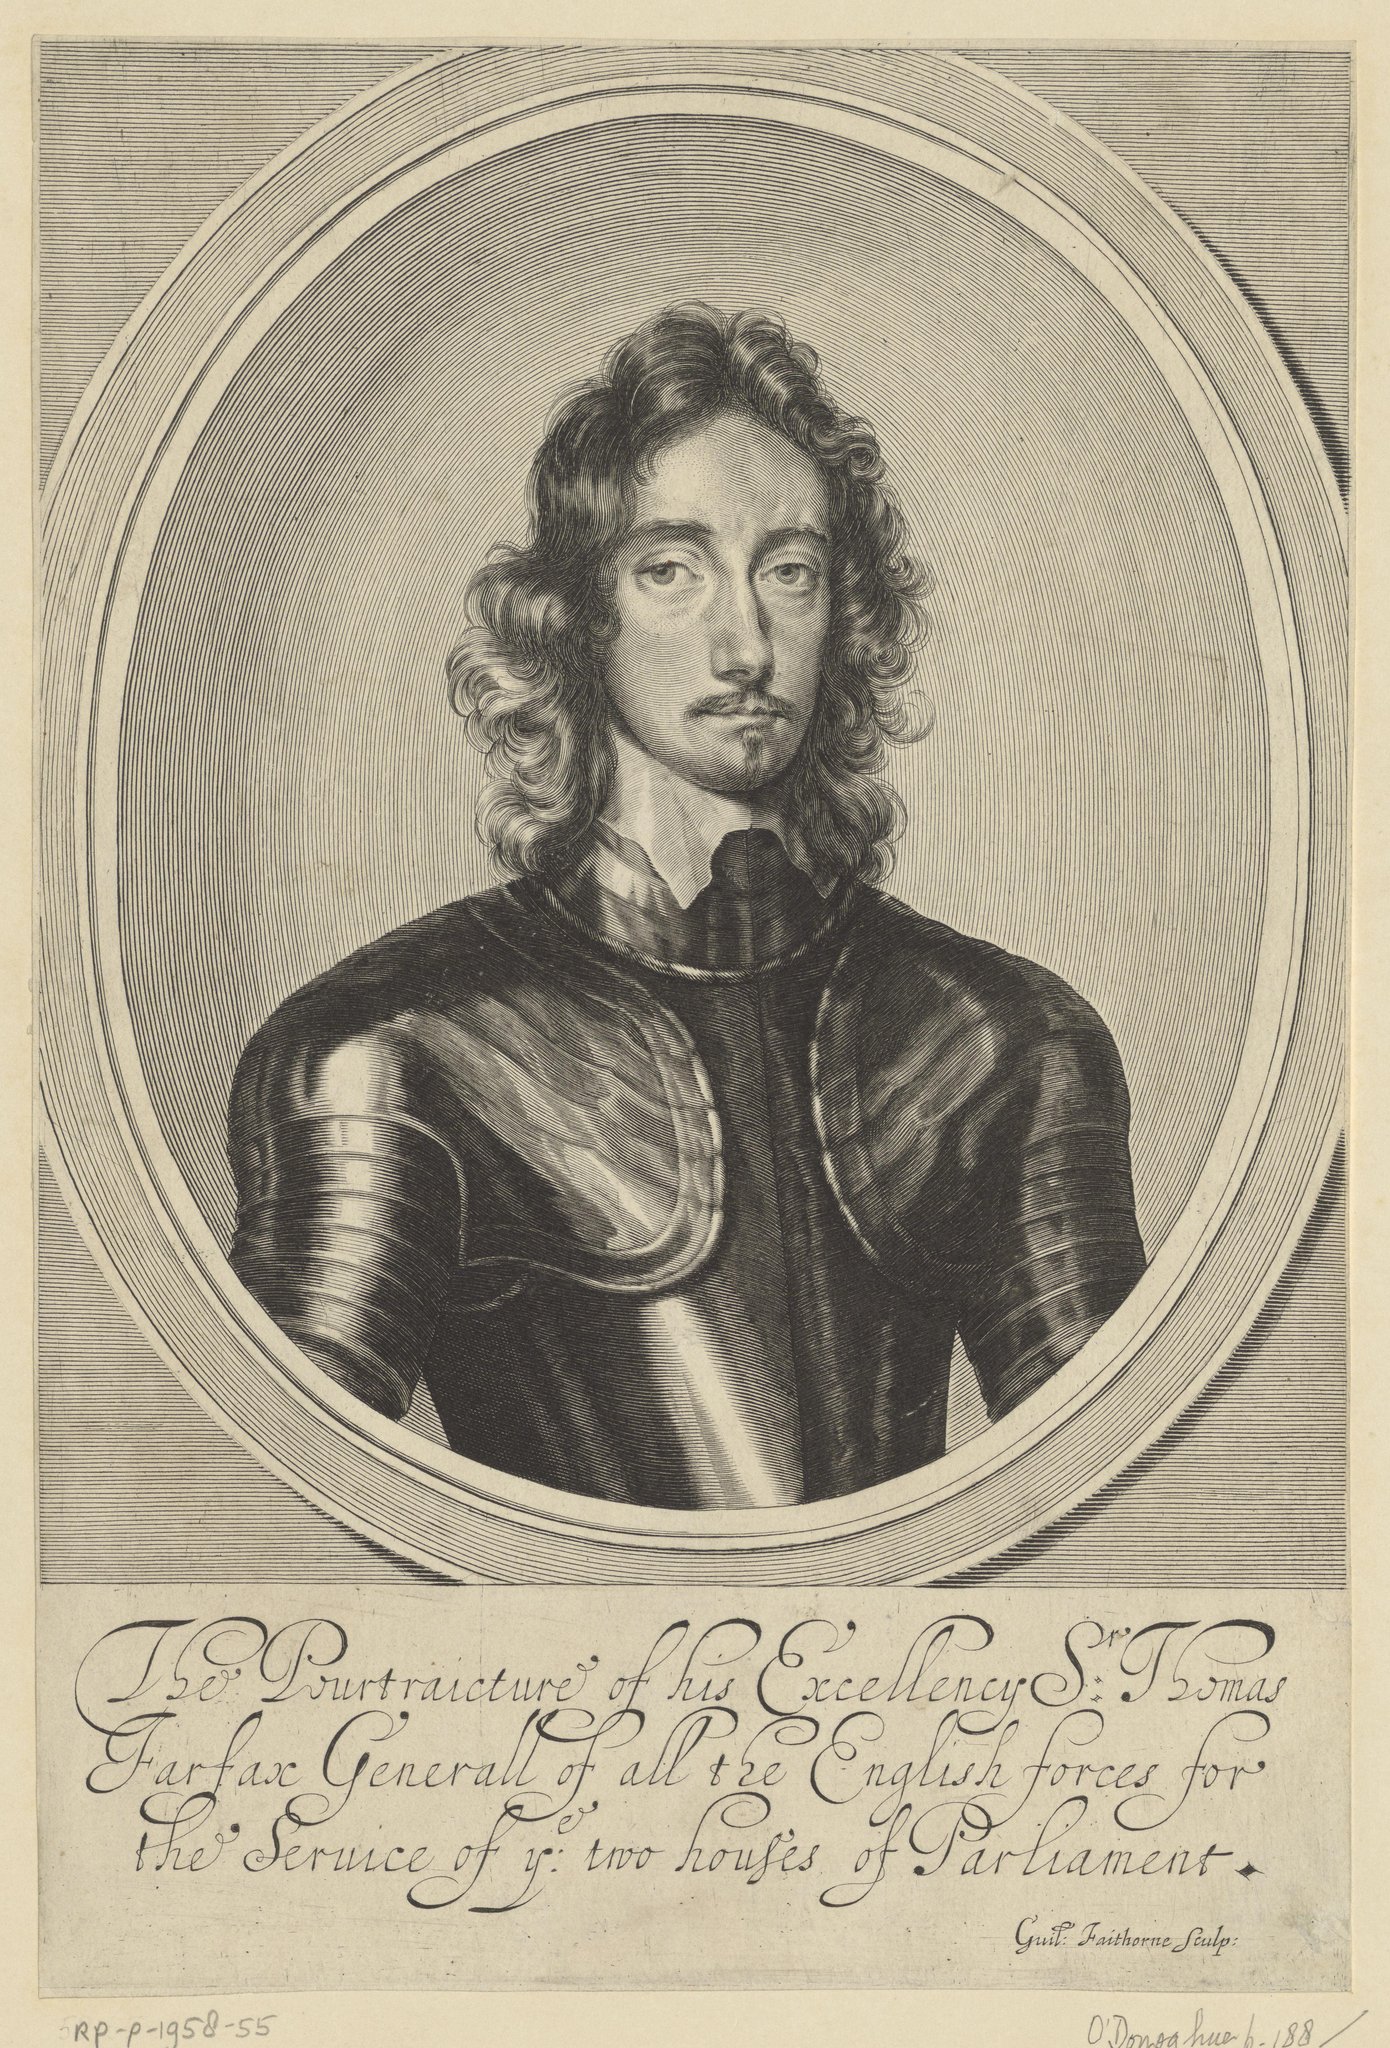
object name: print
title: Portret van Thomas Fairfax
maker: william faithorne (i)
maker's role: print maker, publisher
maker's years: 1616-1691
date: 1645-1646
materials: paper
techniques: engraving, etching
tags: commander-in-chief, general, marshal, historical persons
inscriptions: collector's mark: Lugt 533b